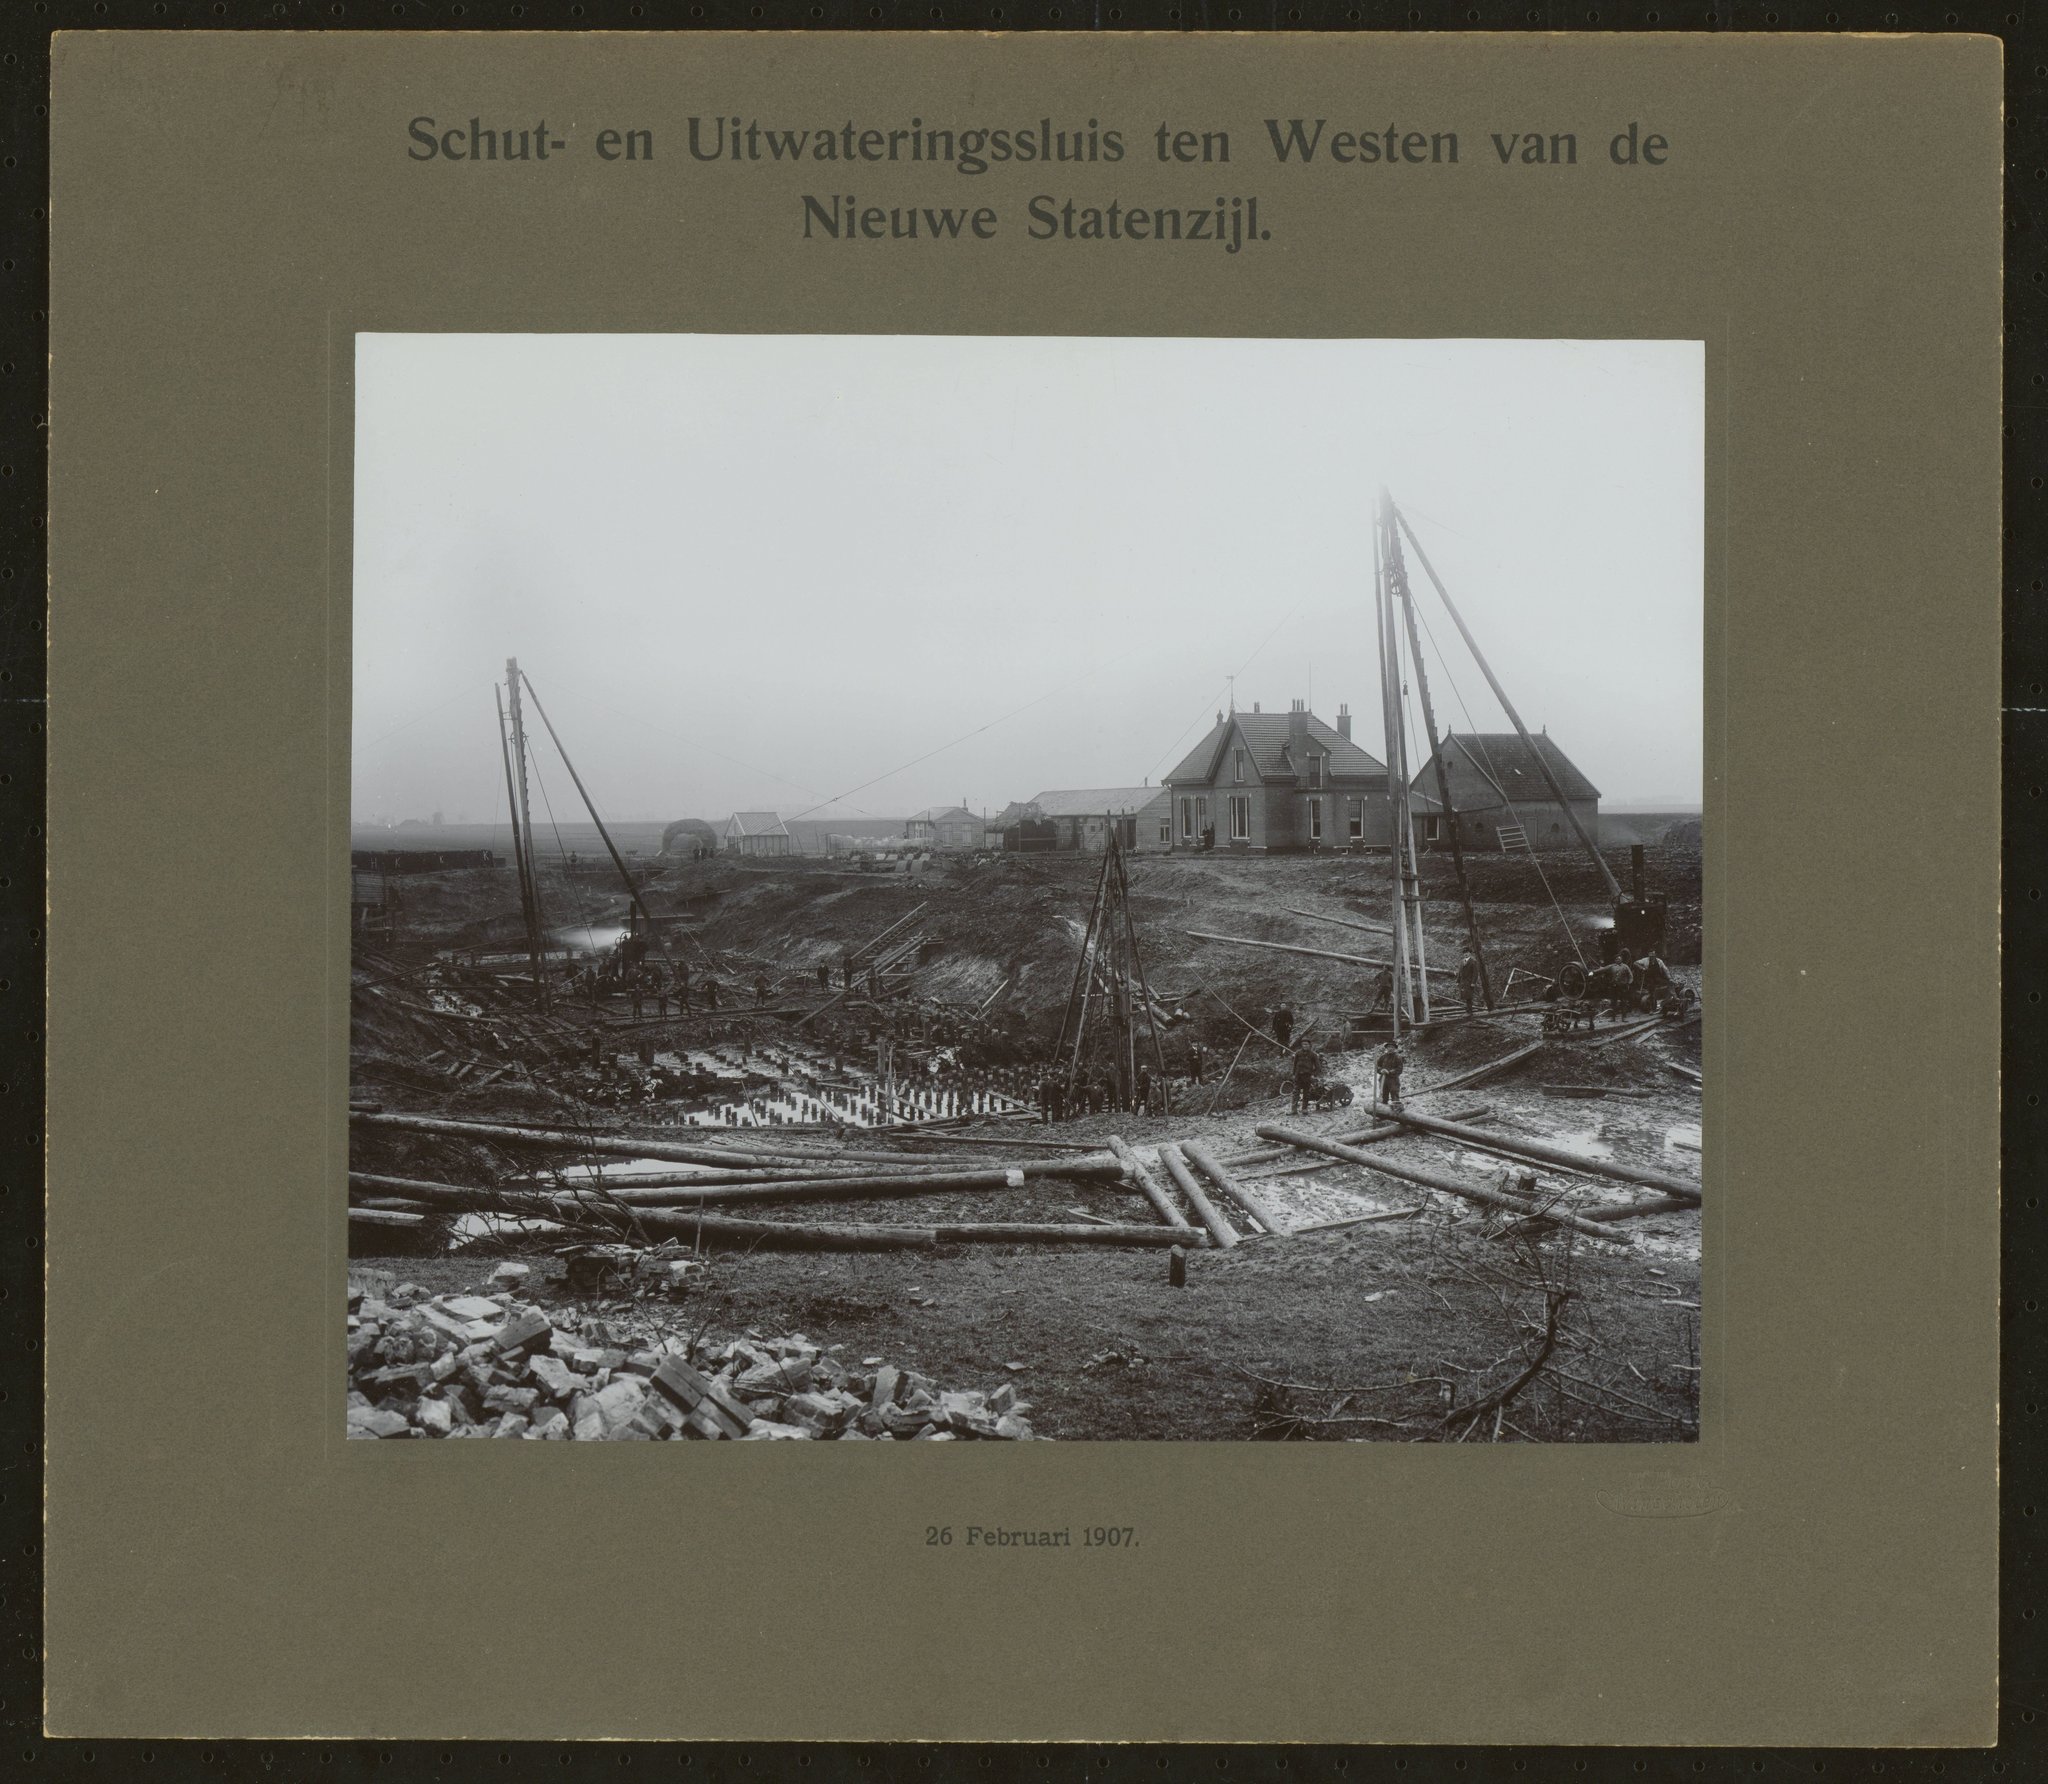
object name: photograph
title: Schut- en Uitwateringssluis ten Westen van de Nieuwe Statenzijl 1907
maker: tonnis post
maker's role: fotograaf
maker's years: 1877-1930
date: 1907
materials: cardboard, paper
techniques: photography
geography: winschoten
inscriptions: date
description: Een van 8 foto's in cassette aangaande een sluis (bij Nieuwe Statenzijl). Foto op blauwgrijs karton geplakt, cassette: paars / bruin. Gedateerd. Opmerking: zie NG-1976-36-B-1 t/m 8.